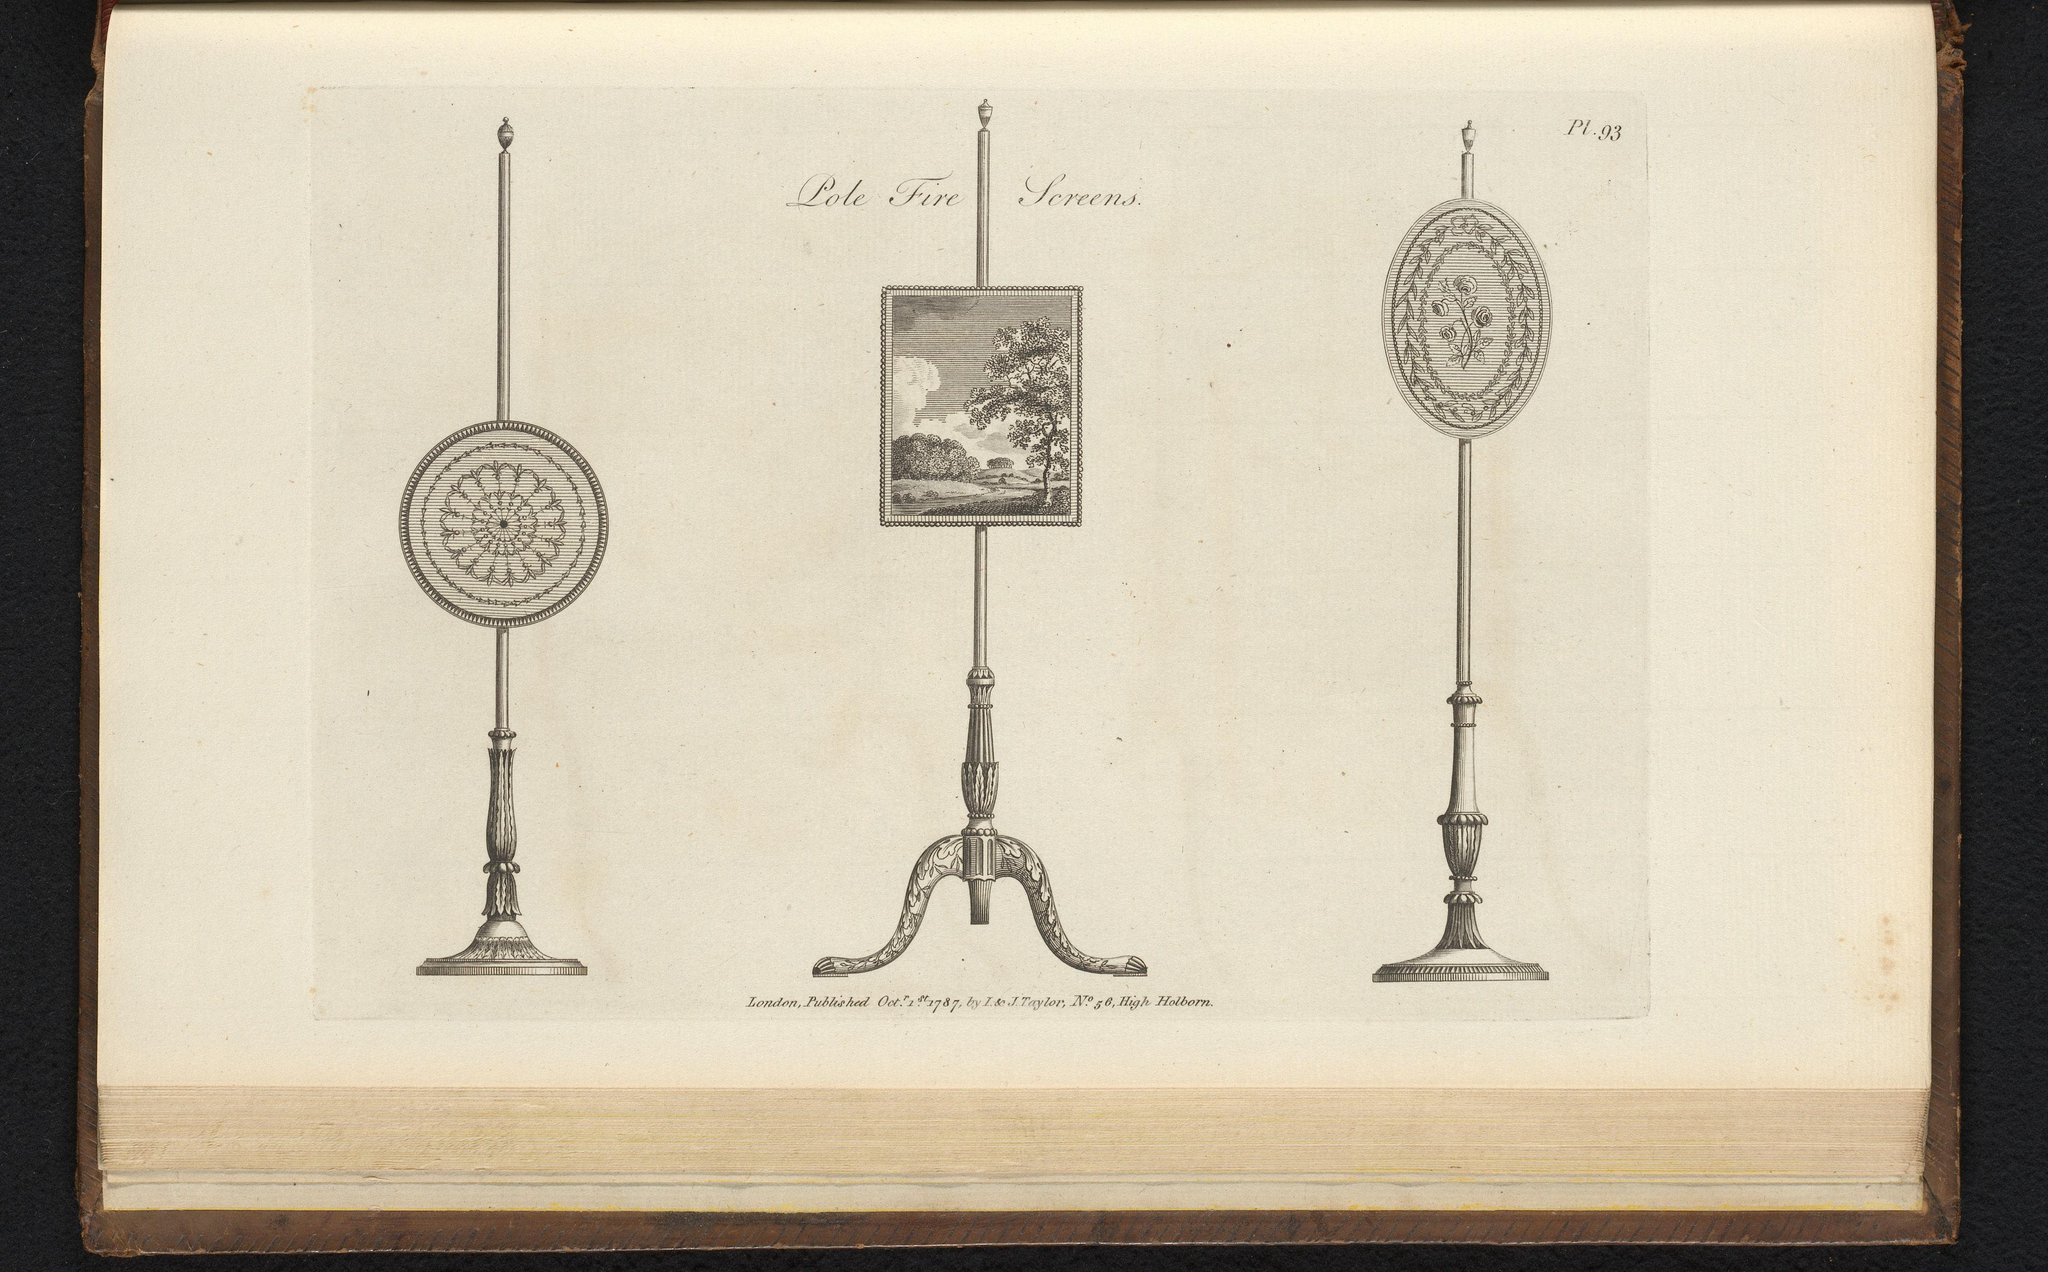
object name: print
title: Meubels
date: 1787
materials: paper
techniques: engraving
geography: holborn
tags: fire-screen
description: Genummerd: Pl. 93. Prent maakt deel uit van een boek.